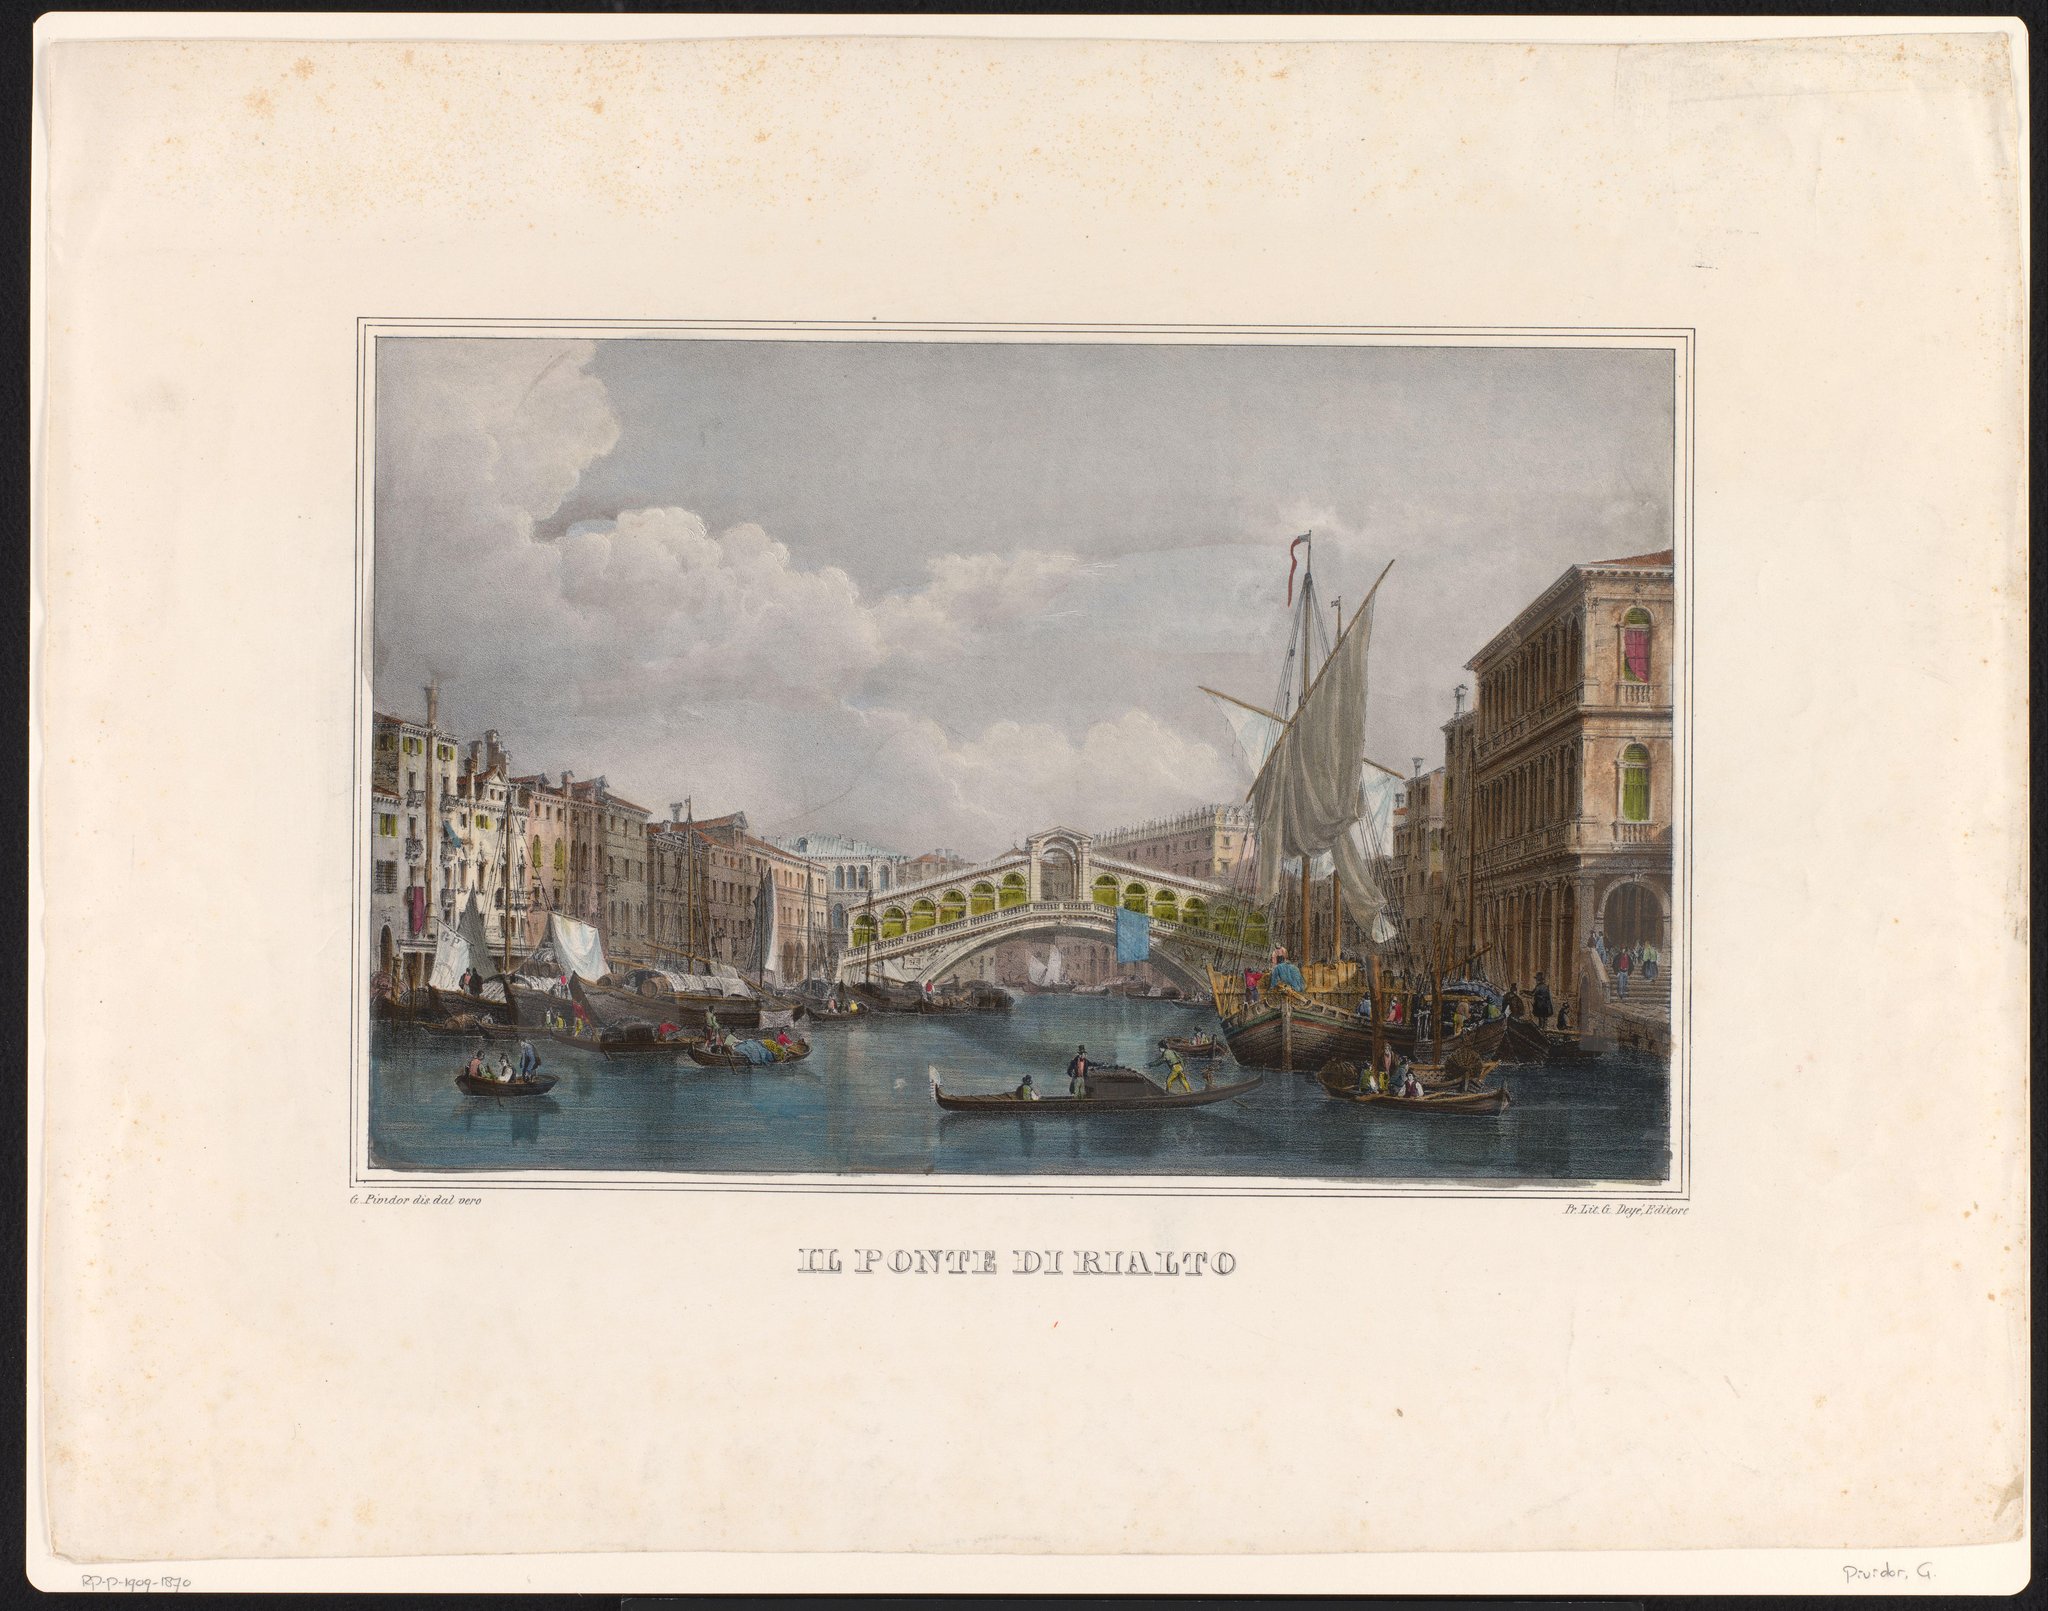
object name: print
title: Il Ponte di Rialto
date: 1826-1872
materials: paper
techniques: hand coloring, lithograph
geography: venice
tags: city-view, and landscape with man-made constructions, canals, waters (in city), bridge in city across river, canal, etc.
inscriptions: collector's mark: Lugt 2228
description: Gezicht op de Rialtobrug over het Canal Grande te Venetië.